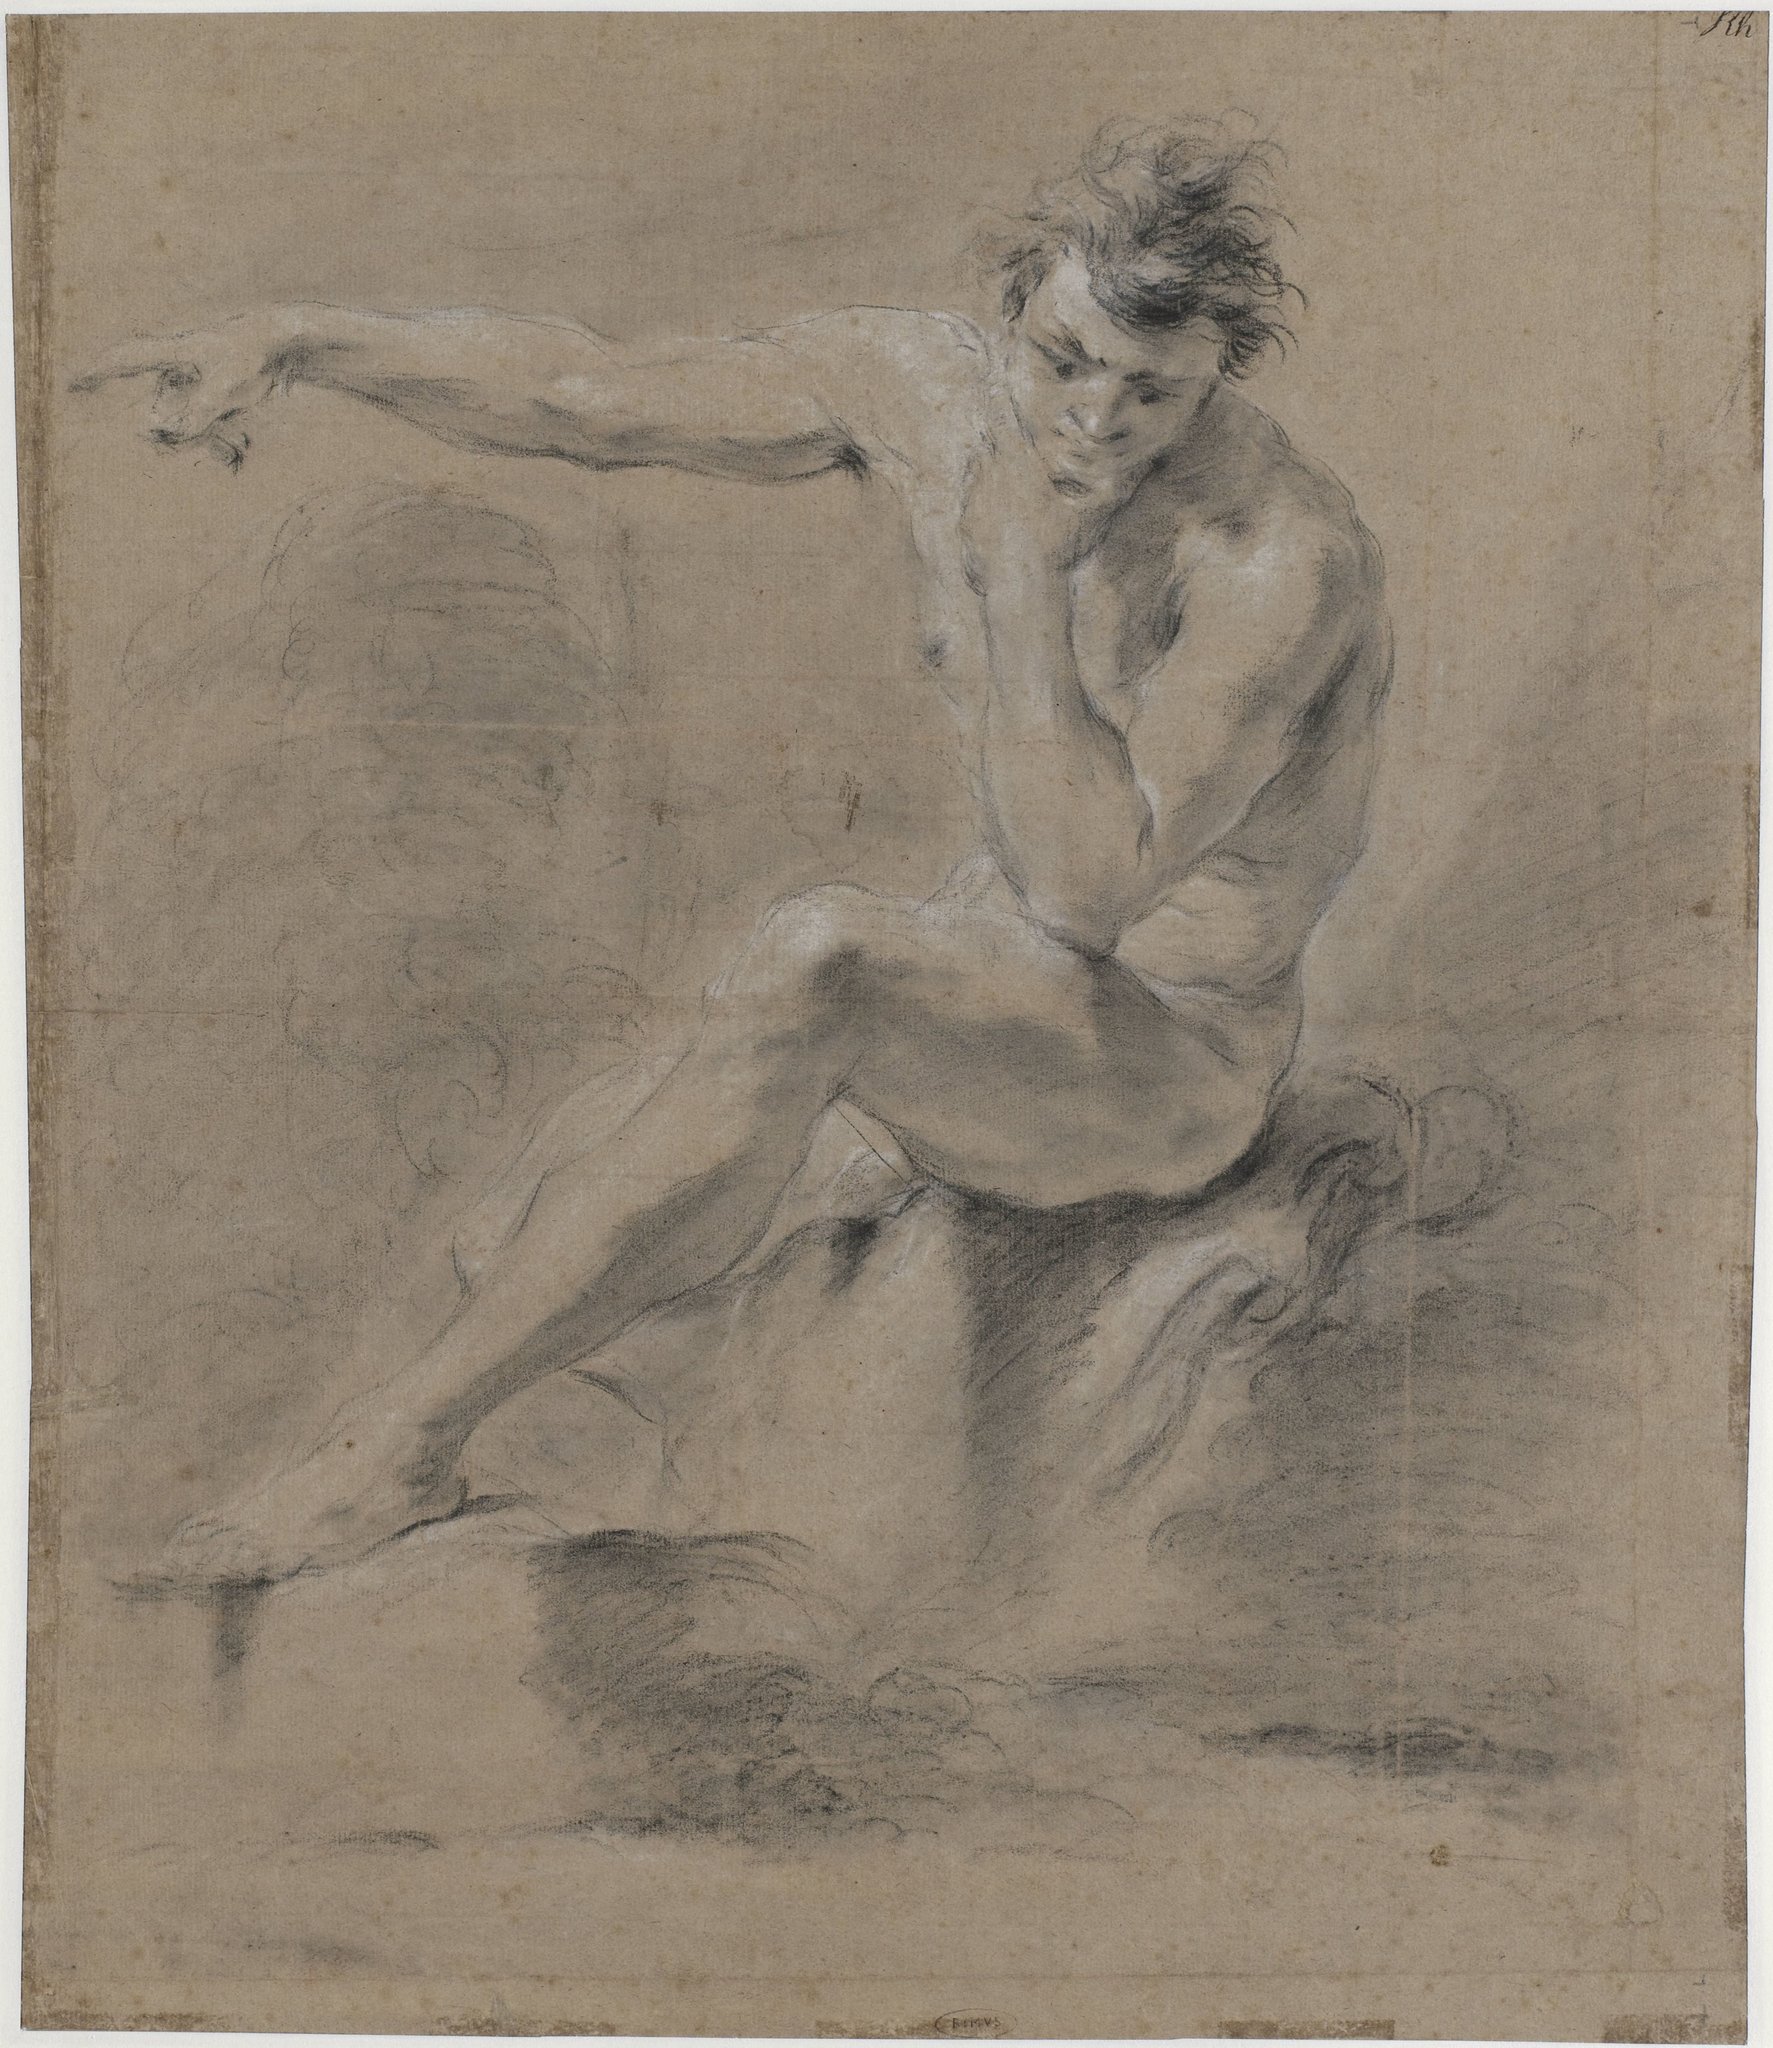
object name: drawing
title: Zittend mannelijk naakt, naar links, de armen op de rug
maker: jan willem pieneman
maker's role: draughtsman, painter, print maker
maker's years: 1779-1853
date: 1789-1853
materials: chalk, paper